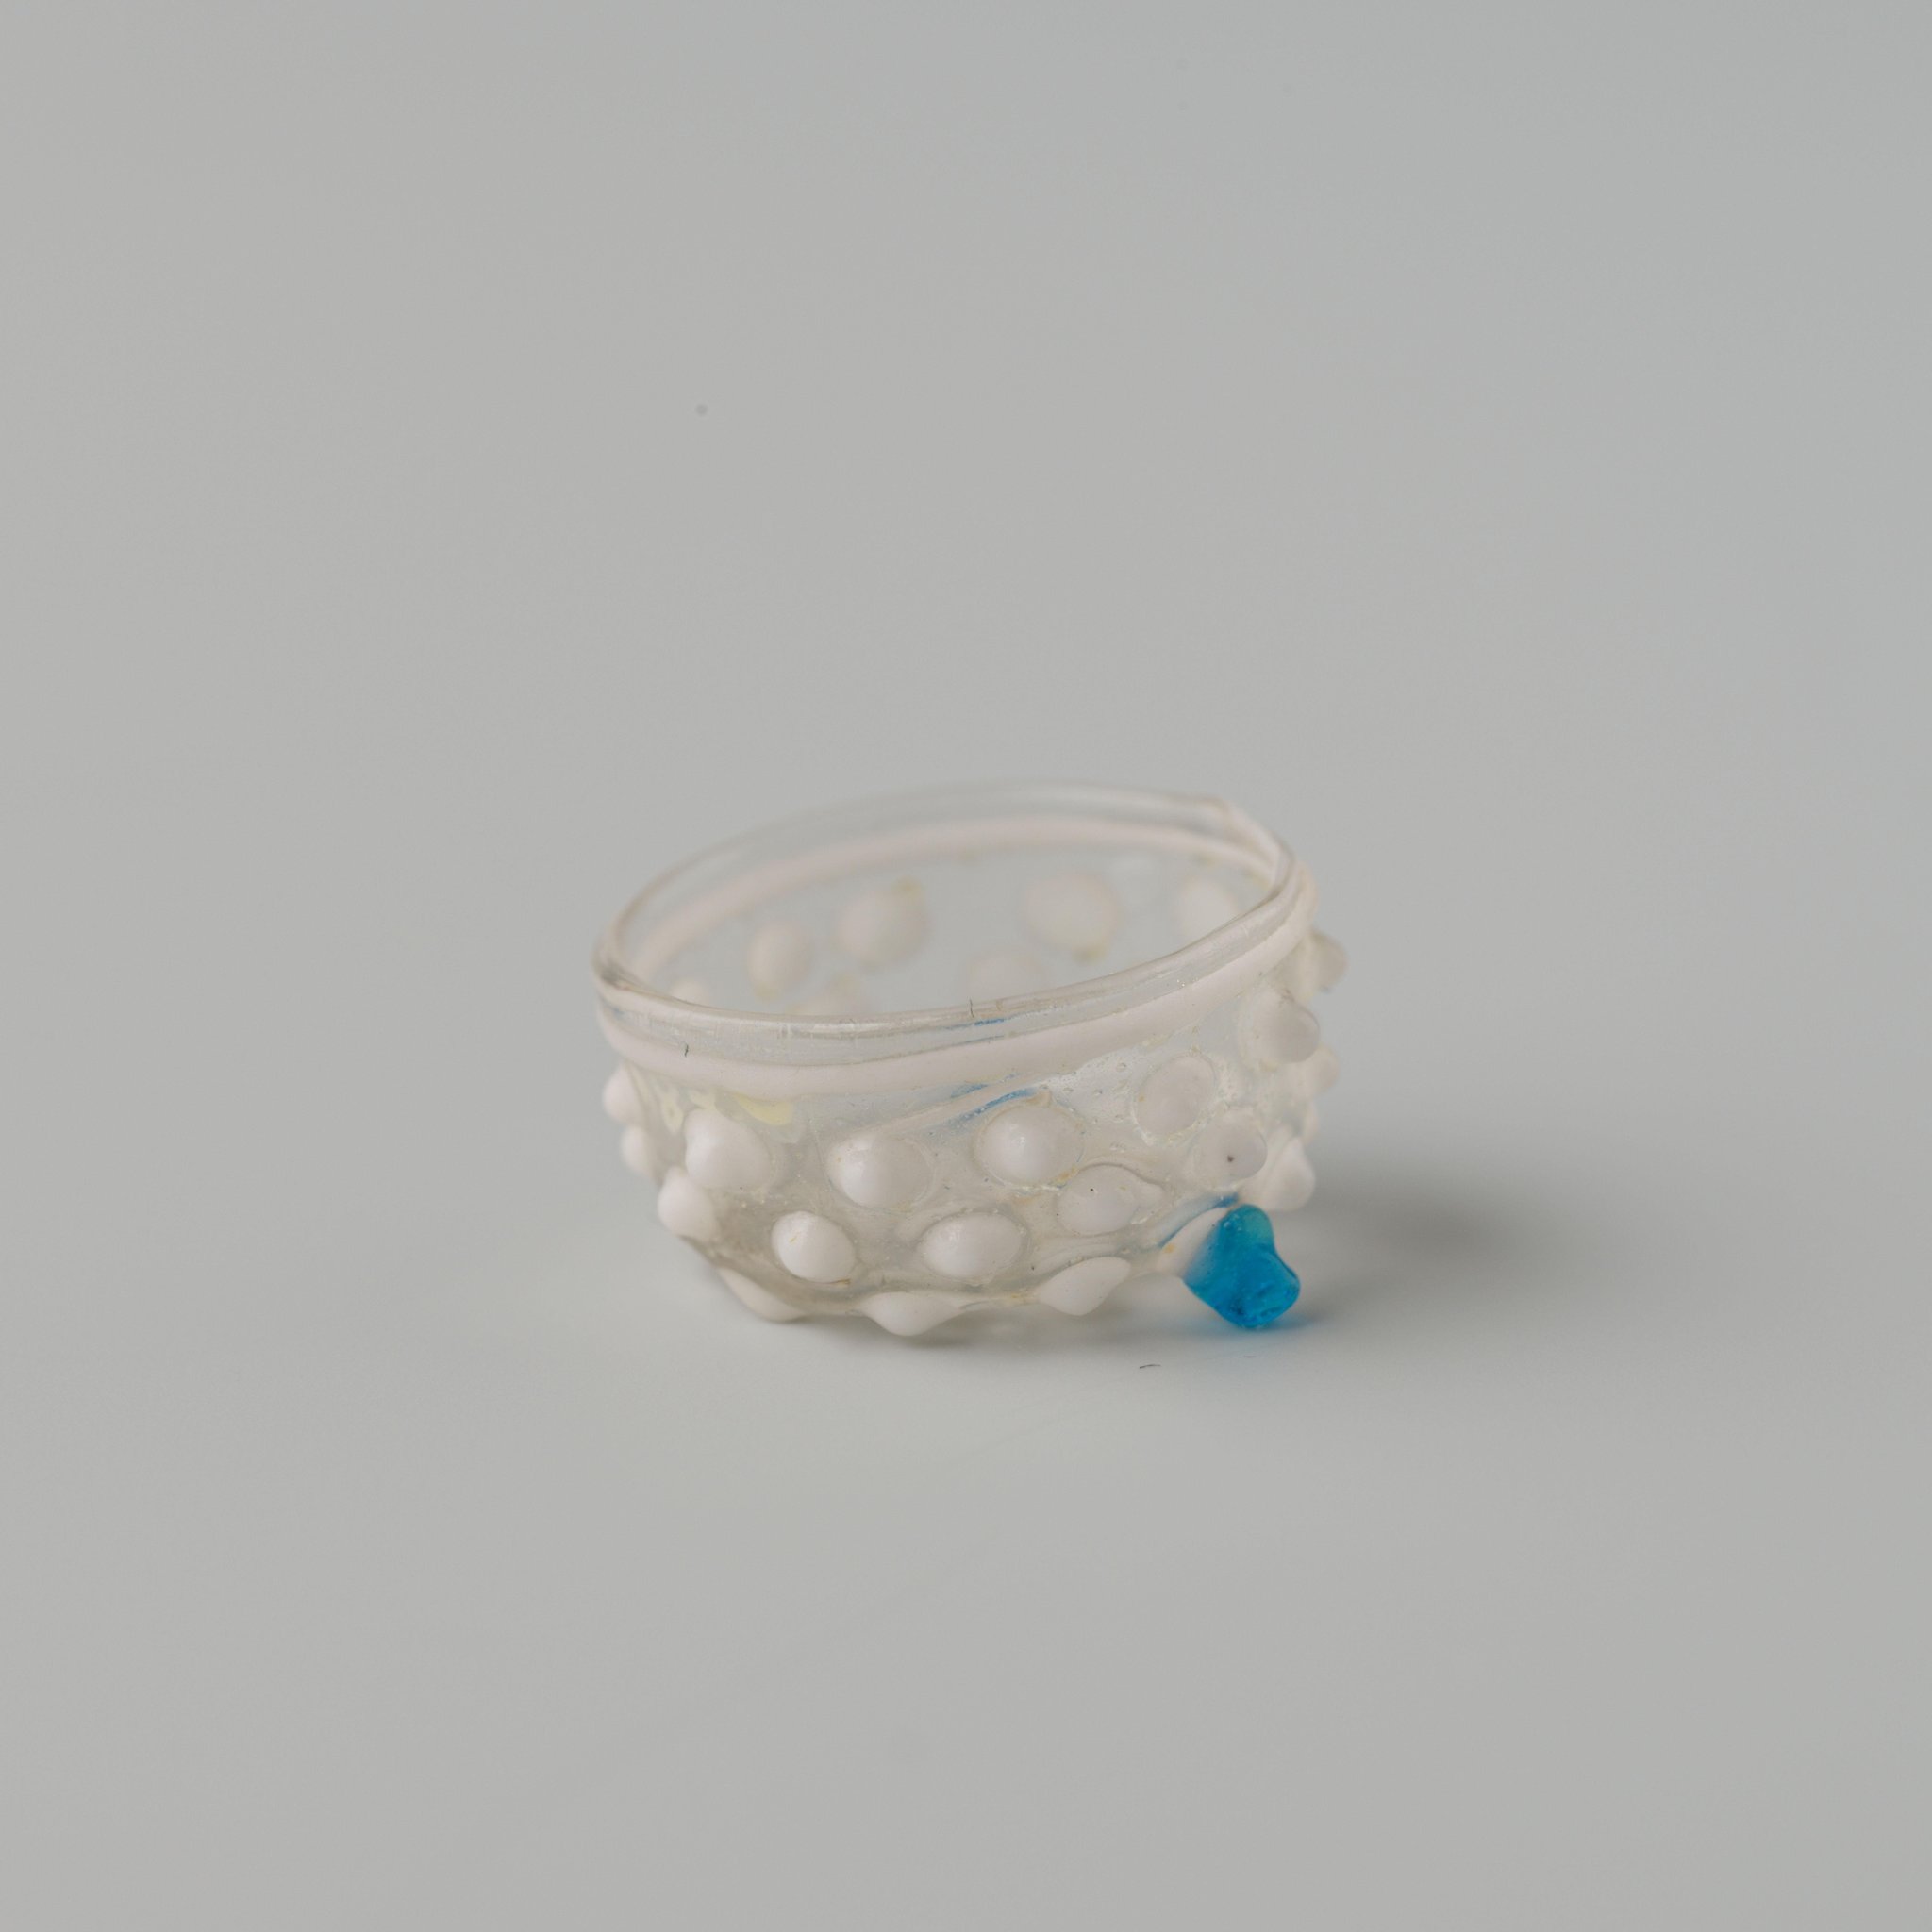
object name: miniature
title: Nap van helder kleurloos glas versierd met witte noppen en witte draad om de rand, staand op (oorspronkelijk) drie bolpootjes. Twee bolpootjes ontbreken.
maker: Anonymous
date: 1675-1710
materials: glass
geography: amsterdam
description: Nap van helder glas, versierd met witte noppen en witte draad om de rand, staand op (oorspronkelijk) drie bolpootjes. Twee bolpootjes ontbreken.